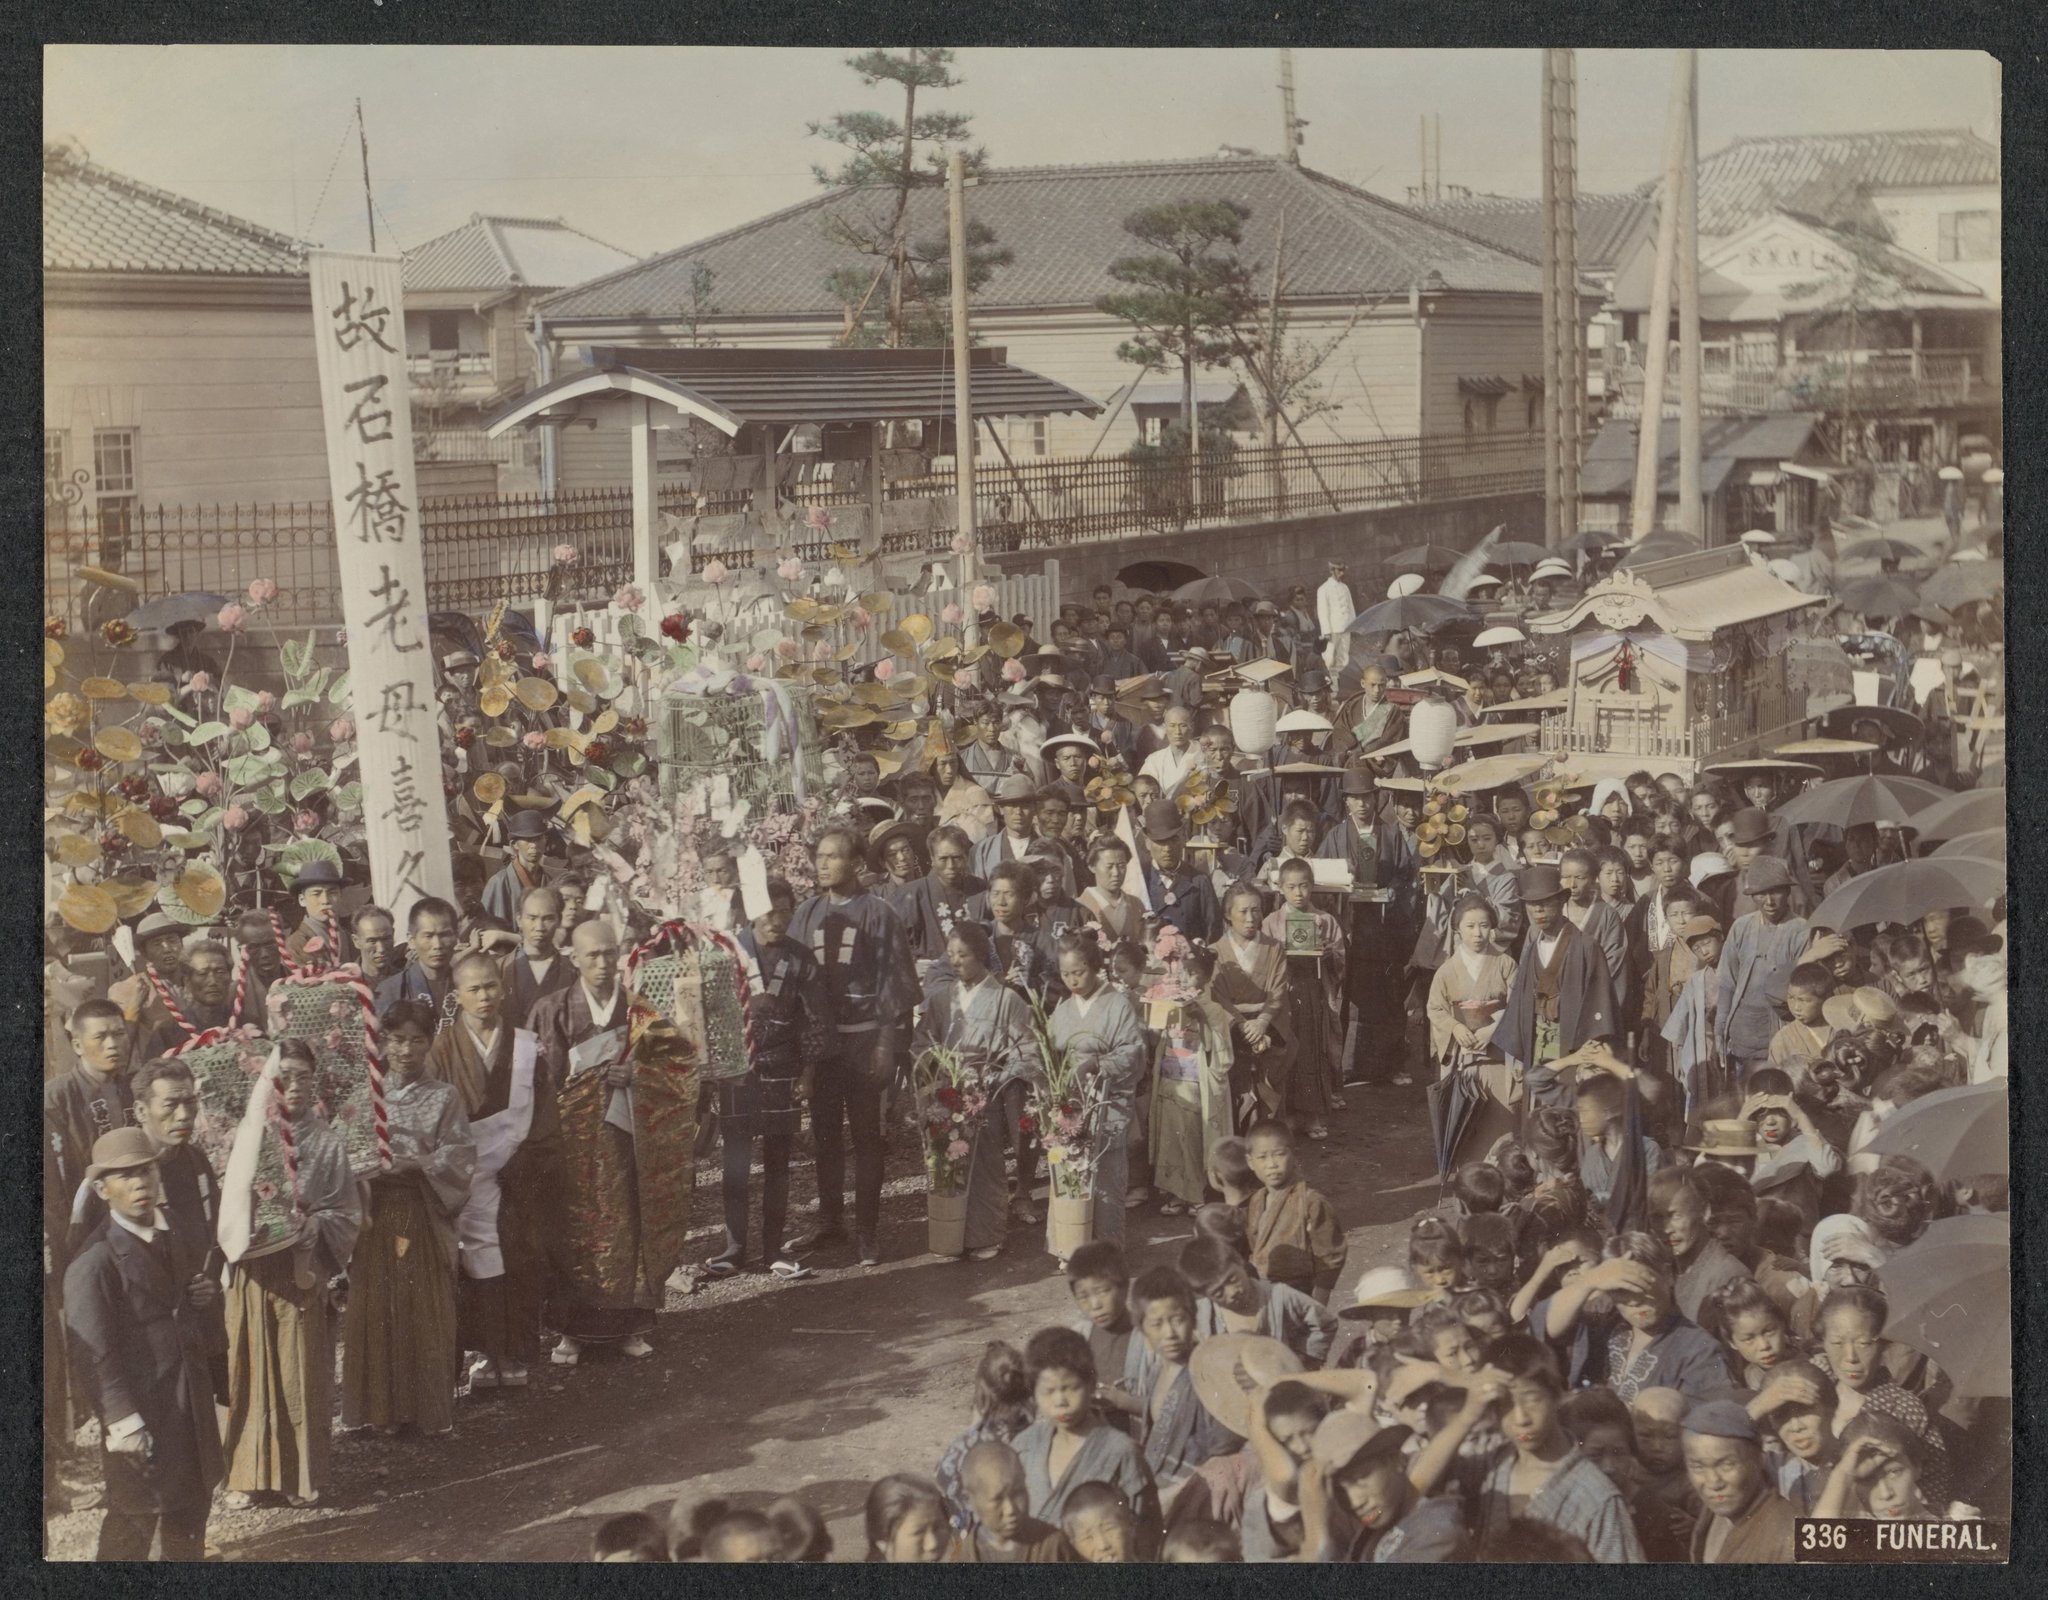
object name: photograph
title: Funeral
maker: kusakabe kimbei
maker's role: fotograaf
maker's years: 1841-1934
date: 1890-1894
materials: cardboard, paper, photographic support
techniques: albumen print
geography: japan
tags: funerary ceremonial, japan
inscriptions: negative number: ‘336’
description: Onderdeel van Album met 69 foto's van een reis door Japan.